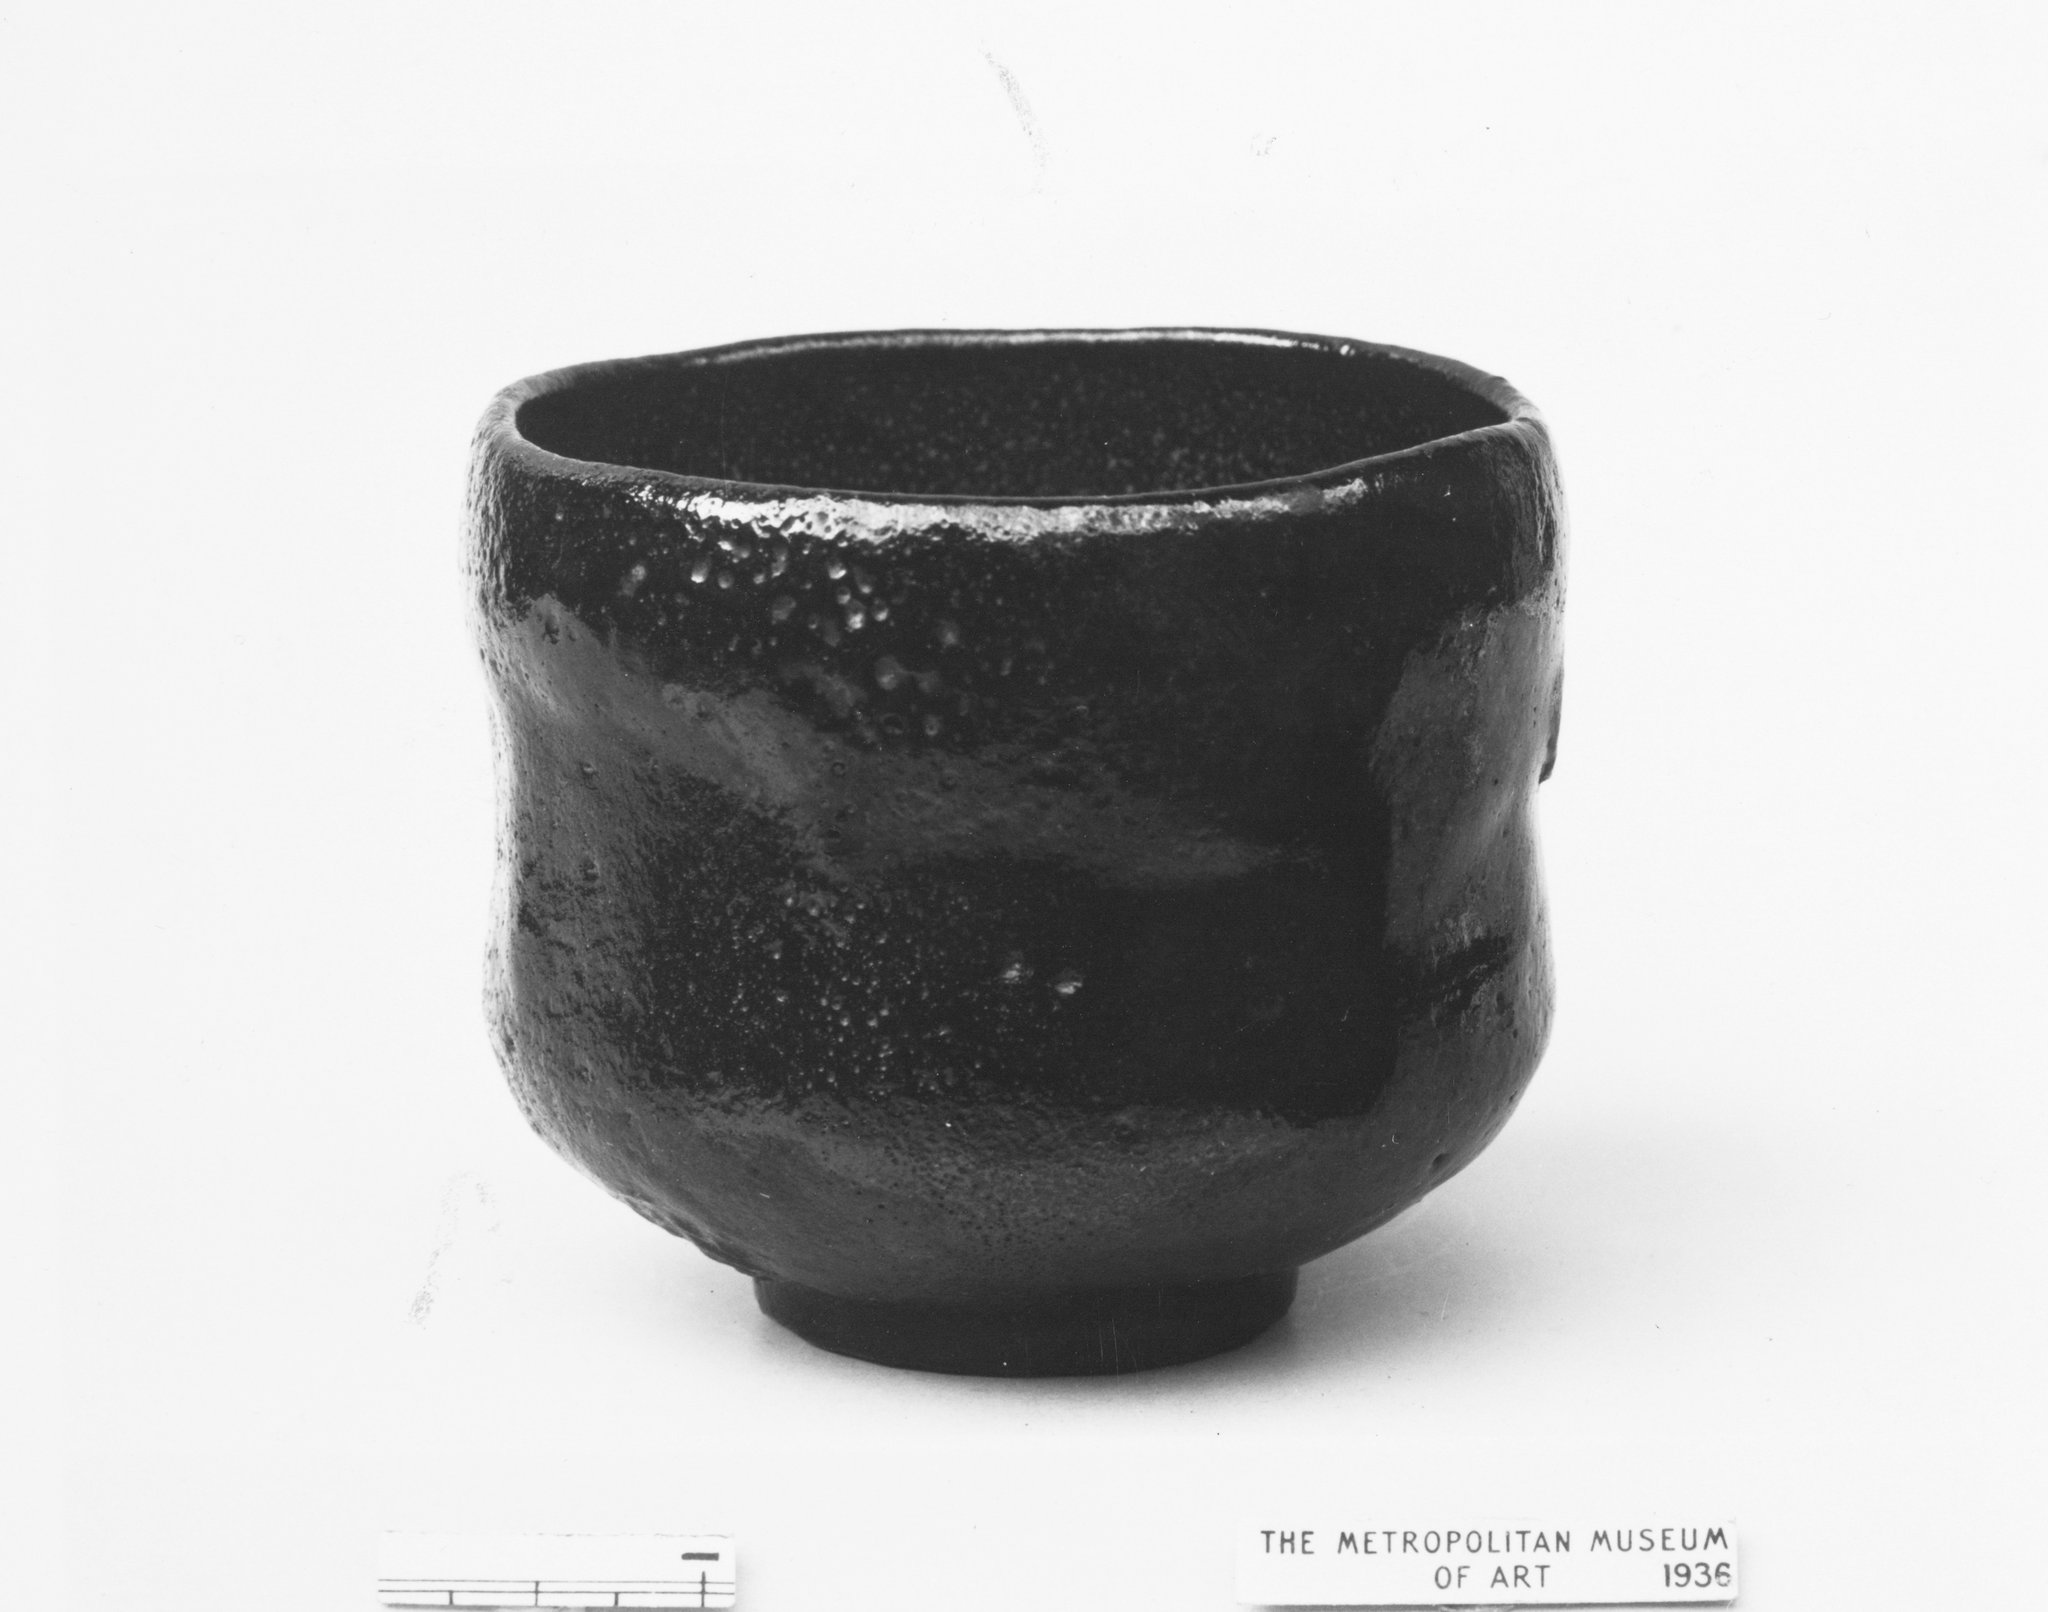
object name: teabowl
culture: japanese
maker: raku sanyū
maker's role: artist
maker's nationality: japanese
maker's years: 1685-1739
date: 1730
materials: clay, glaze